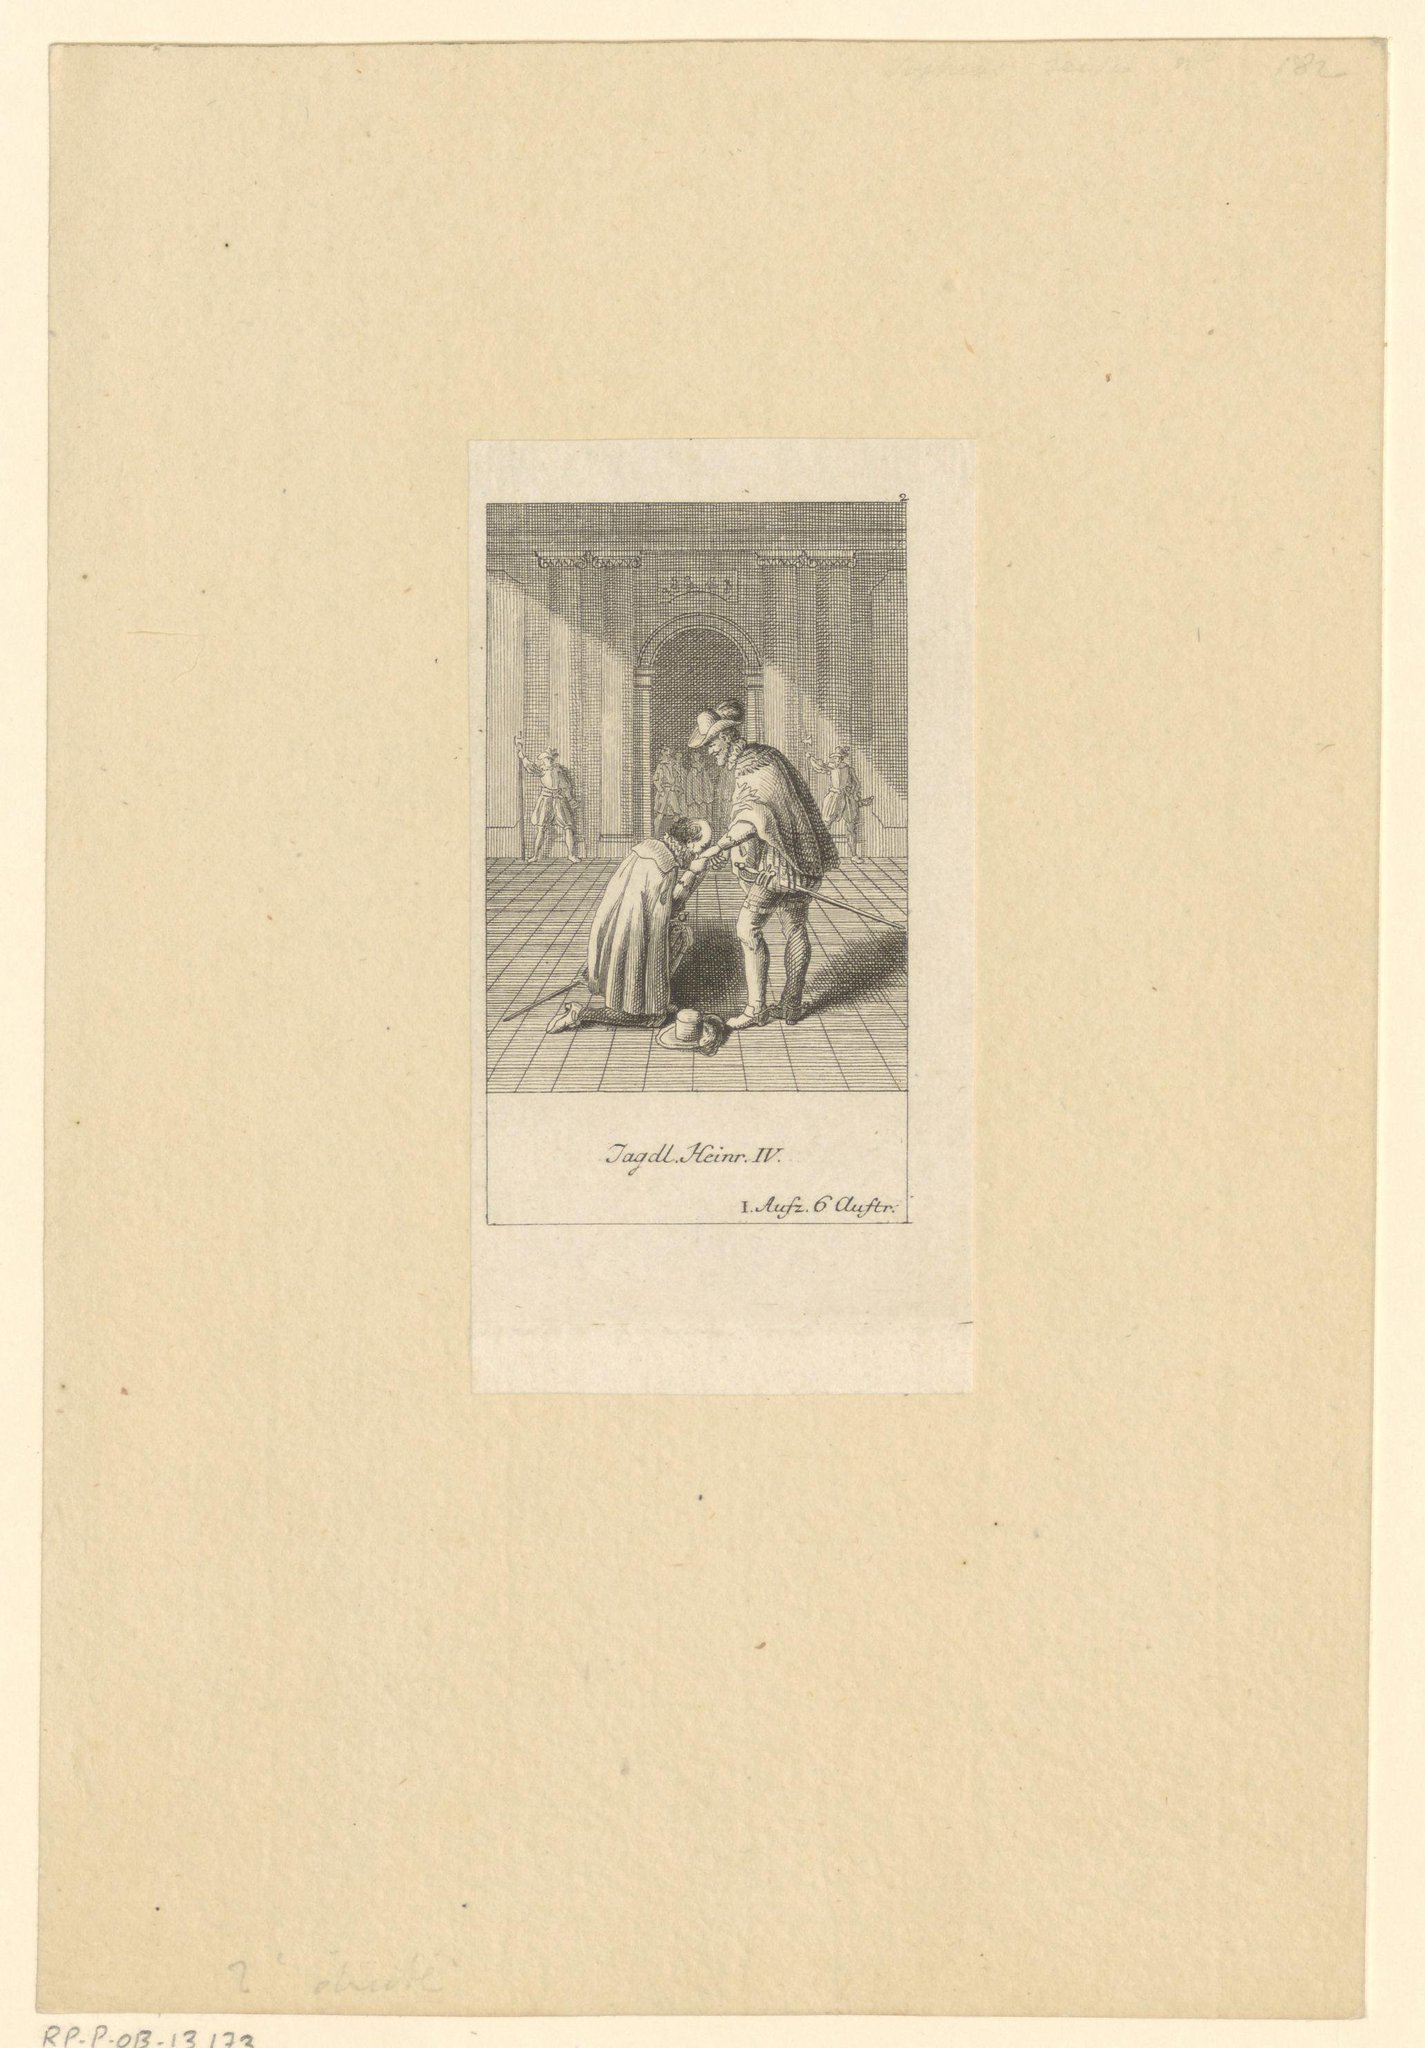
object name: print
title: Rosny geknield voor Hendrik IV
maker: daniel berger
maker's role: print maker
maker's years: 1744-1824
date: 1774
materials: paper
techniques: etching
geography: berlin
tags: hendrik iv (koning van frankrijk en navarra), literary characters and objects, kneeling figure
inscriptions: collector's mark: Lugt 2228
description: Prent afkomstig uit: Genealogischen Calender für West-Preussen auf das Jahr 1775, uitgegeven op kosten van de Konigliche Academie der Wissenschaften. Deze prent maakt deel uit van een serie van twaalf prenten, gedrukt van een koperplaat. De prenten tonen scènes uit het toneelstuk 'La partie de chasse de Henri IV' (1767) van Charles Collé.